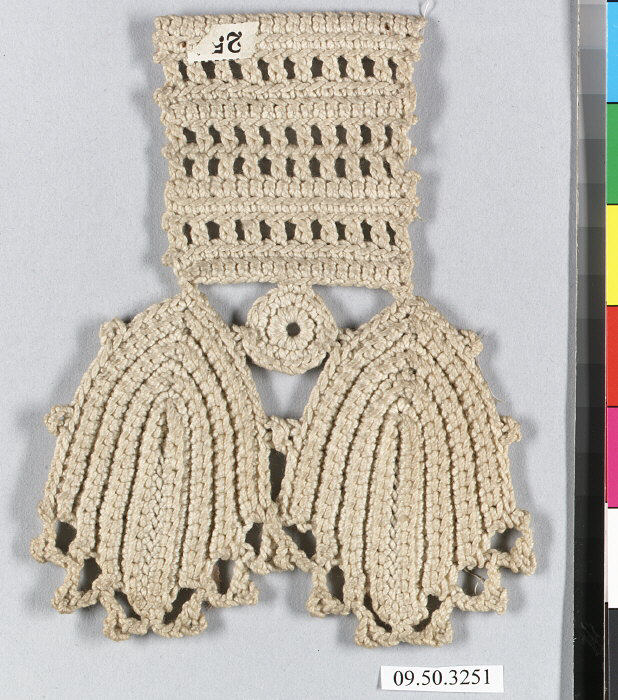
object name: sample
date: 1801-1900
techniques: crochet